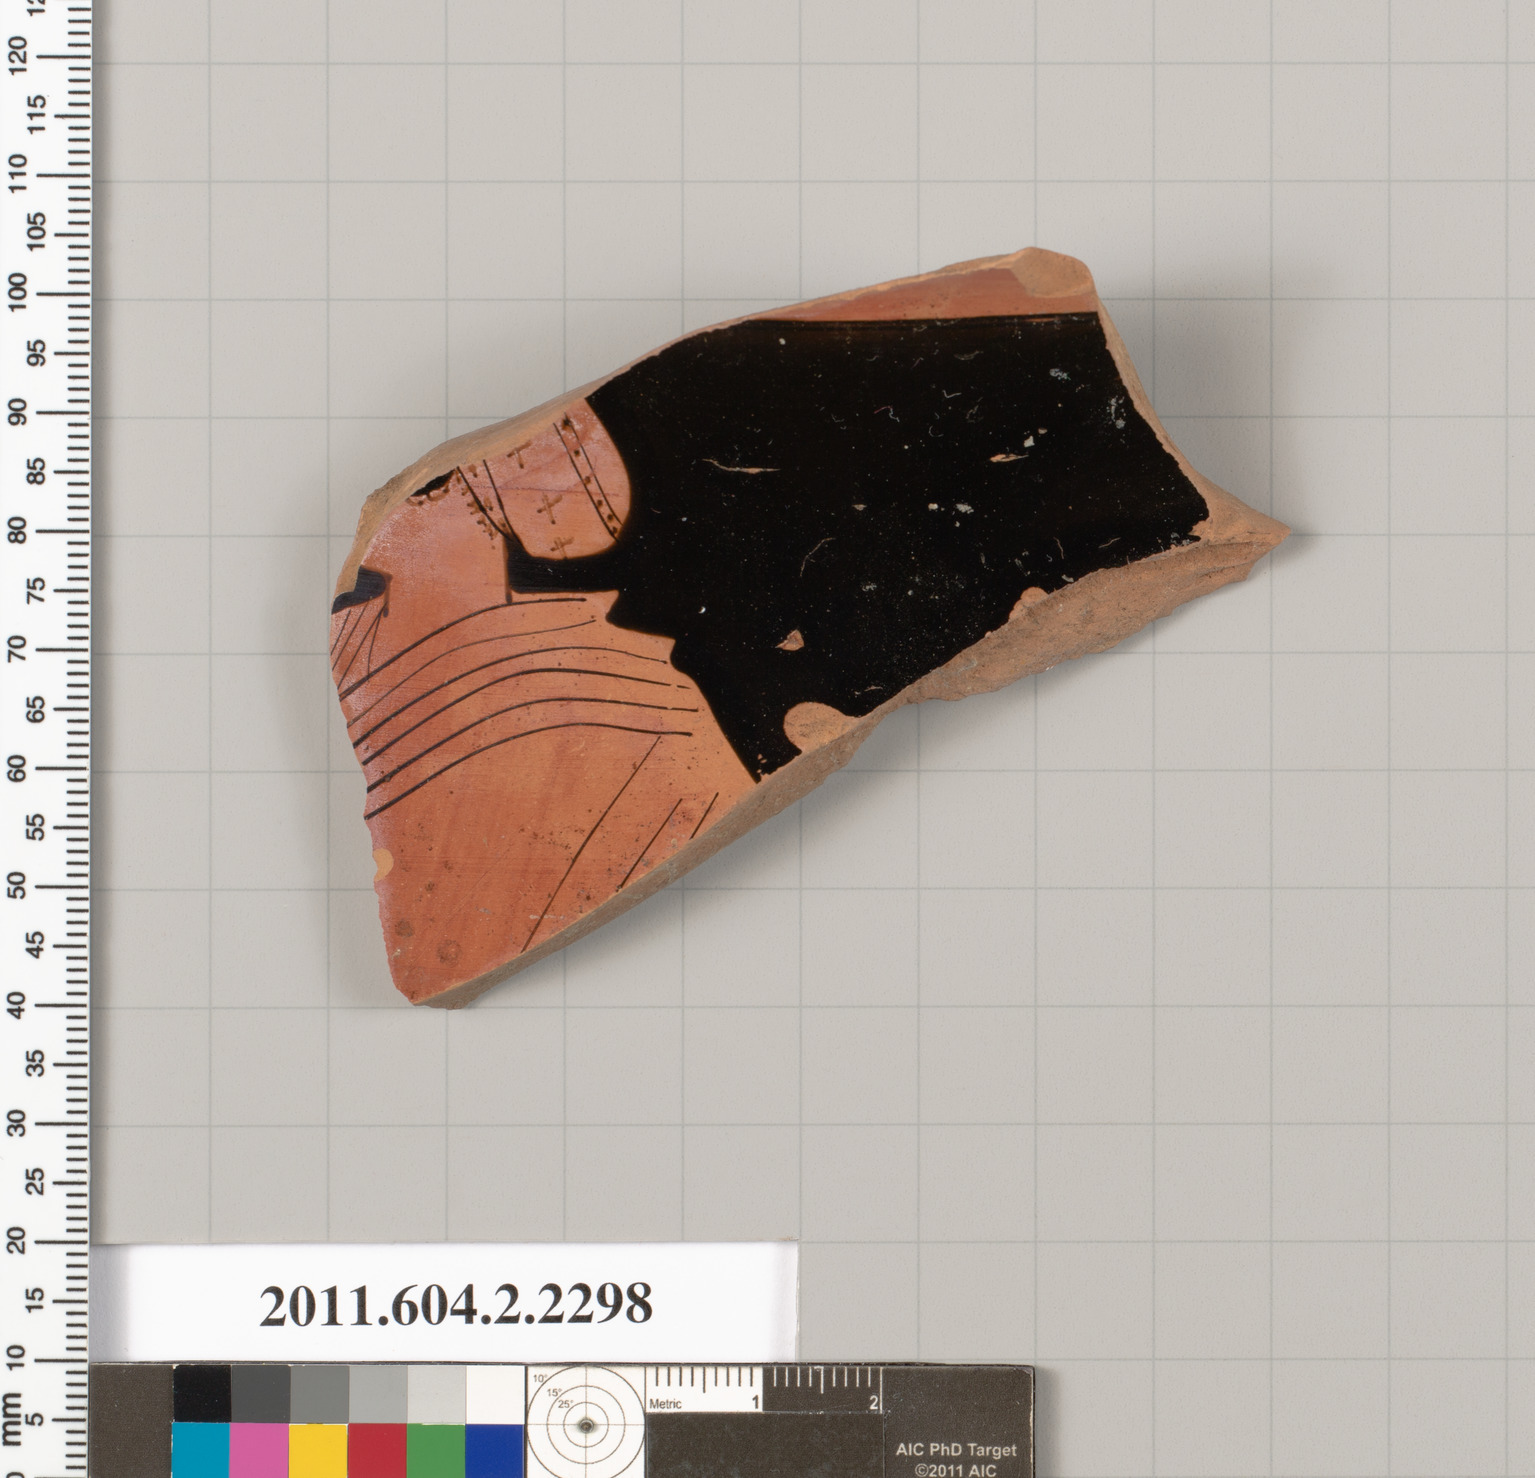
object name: bell krater fragment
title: Terracotta fragment of a bell-krater (bowl for mixing wine and water)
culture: greek, attic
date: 460-440 BCE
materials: terracotta